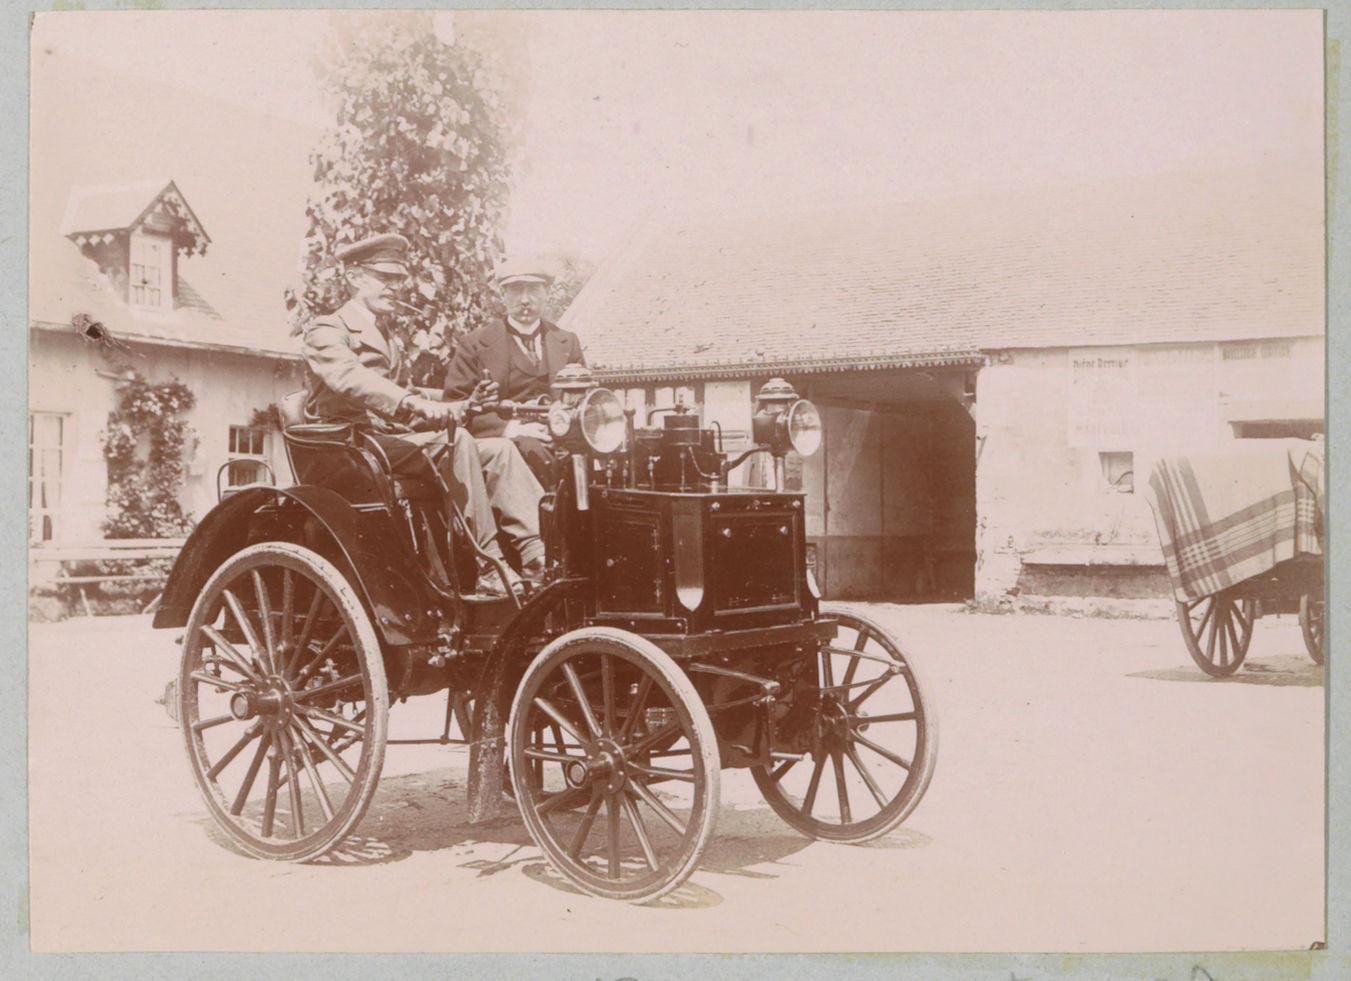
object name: photograph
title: Twee mannen in een automobiel in Varaville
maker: delizy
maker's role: manufacturer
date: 1808-1897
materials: paper, photographic support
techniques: gelatin silver print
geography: varaville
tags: automobile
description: Onderdeel van Fotoalbum van een Franse amateurfotograaf met opnames van uitstapjes in Frankrijk, Spanje, België, Luxemburg en Nederland, de eerste automobielen en autoraces.